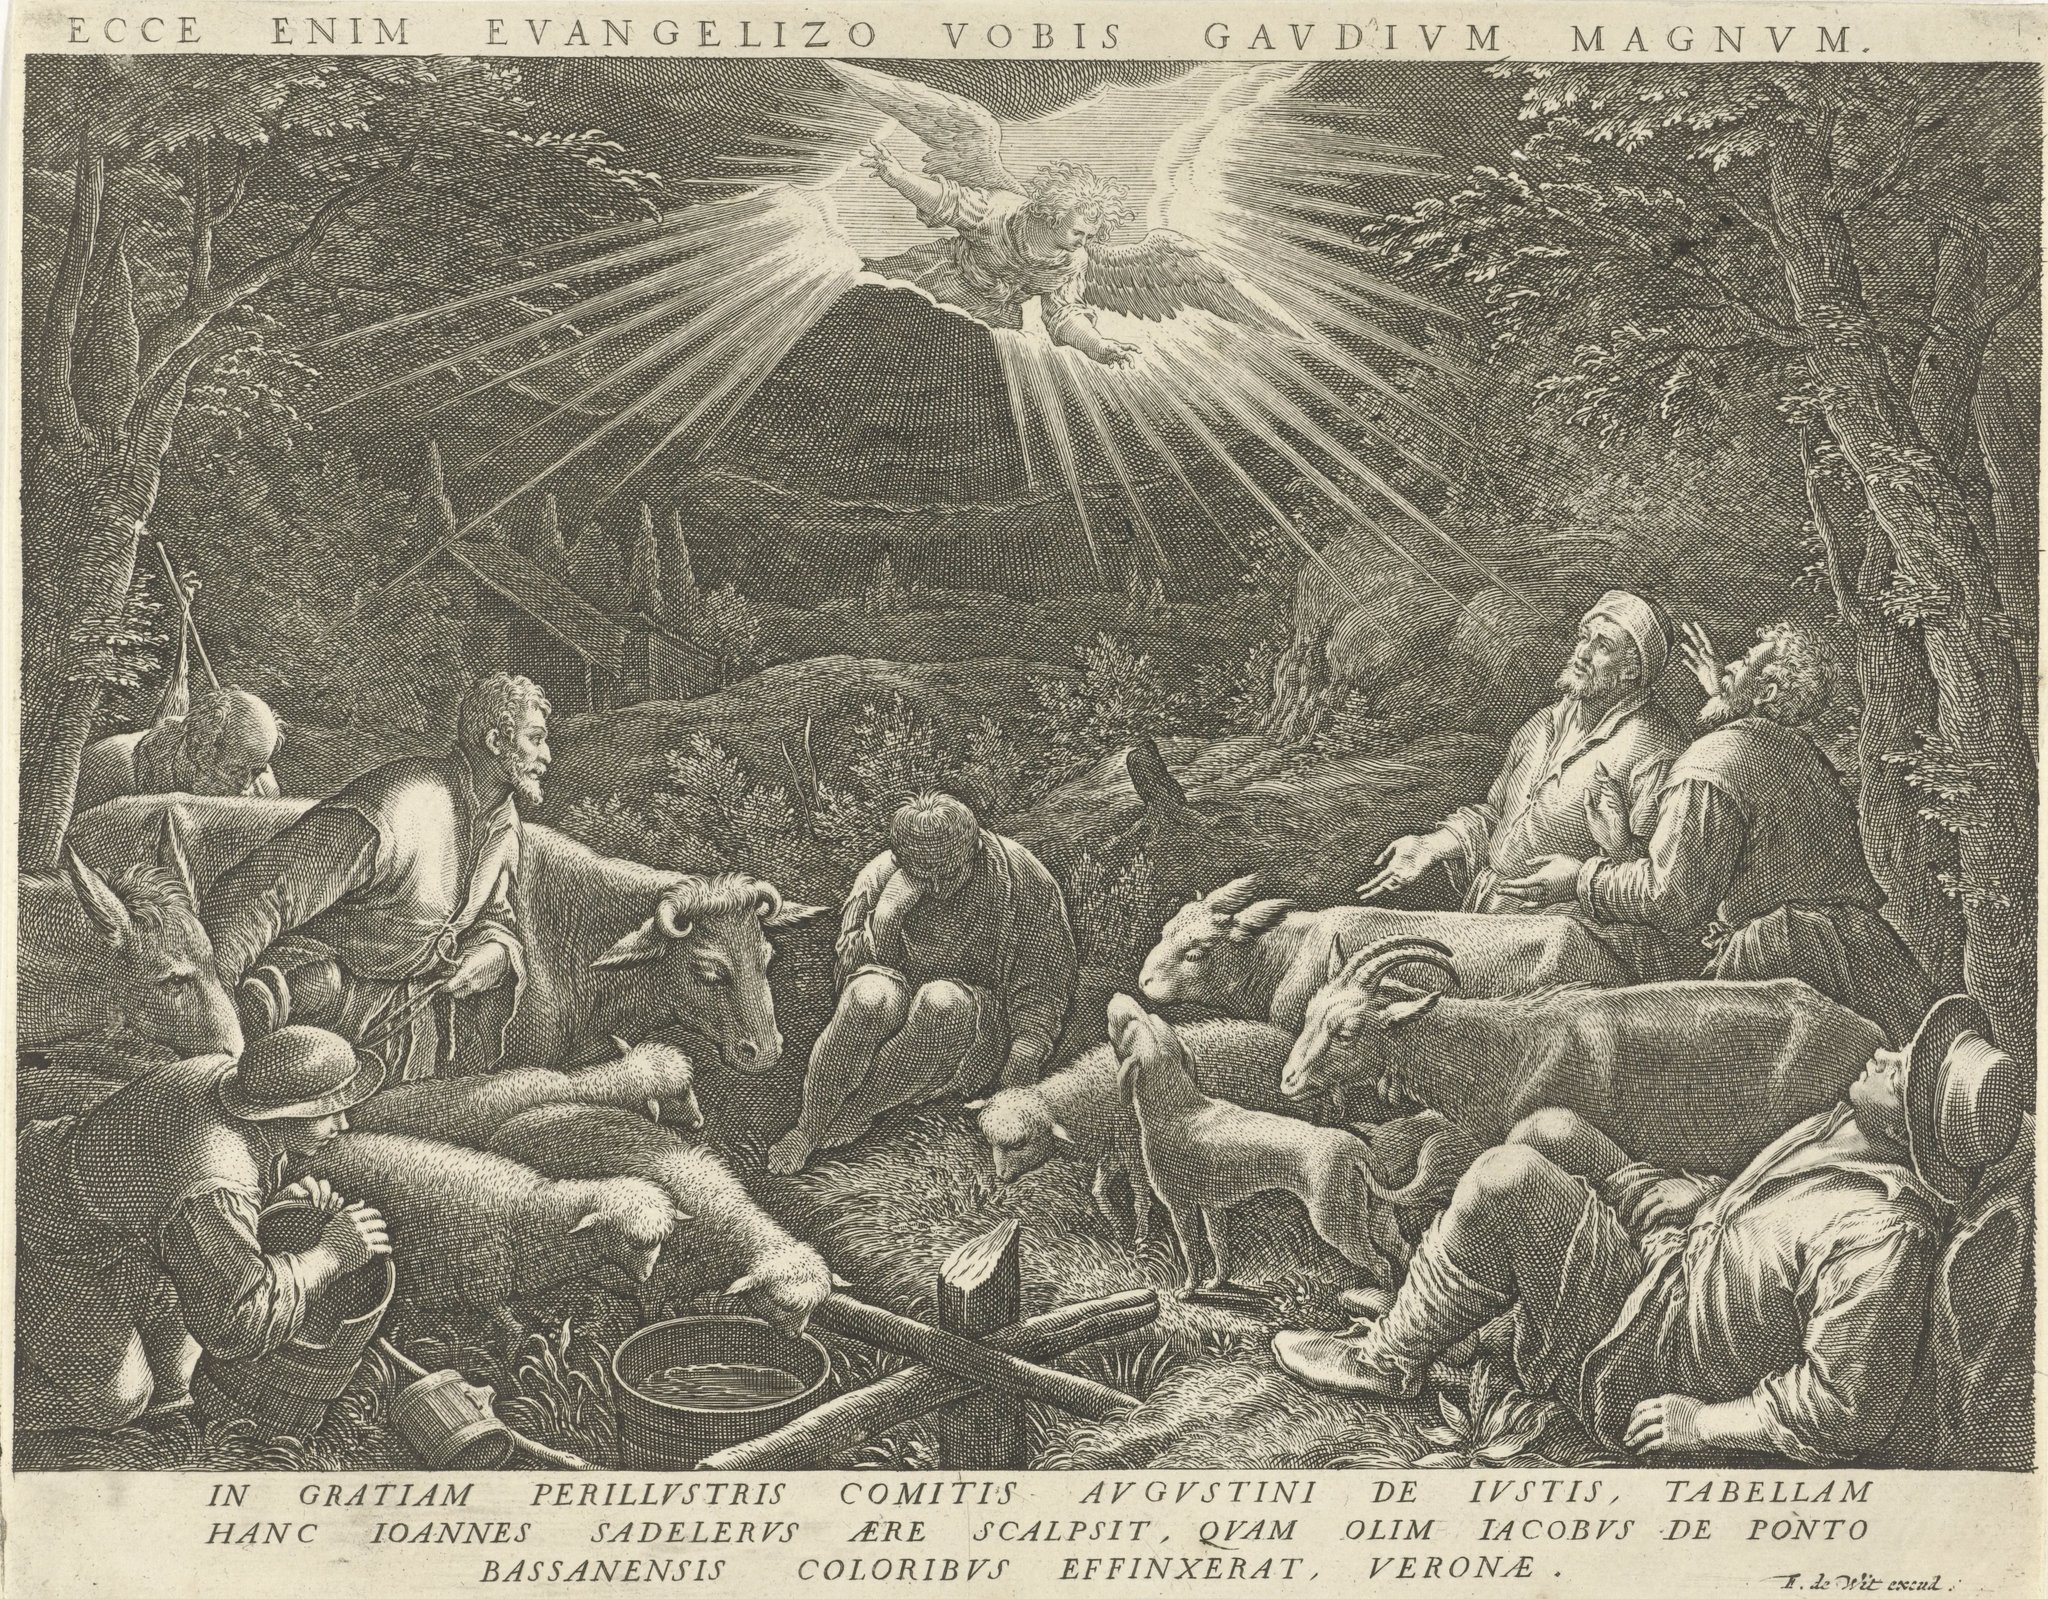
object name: print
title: Verkondiging aan de herders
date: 1560-1600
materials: paper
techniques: engraving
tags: annunciation of christ's birth to the shepherds (and/or shepherdesses) at night; a host of singing angels in the air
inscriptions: collector's mark: Lugt 240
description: In de nacht liggen de herders op de grond te slapen met hun dieren. Een stralende engel komt uit de wolken en verkondigt de geboorte van Christus aan de herders. De prent heeft een Latijns onderschrift met uitleg.